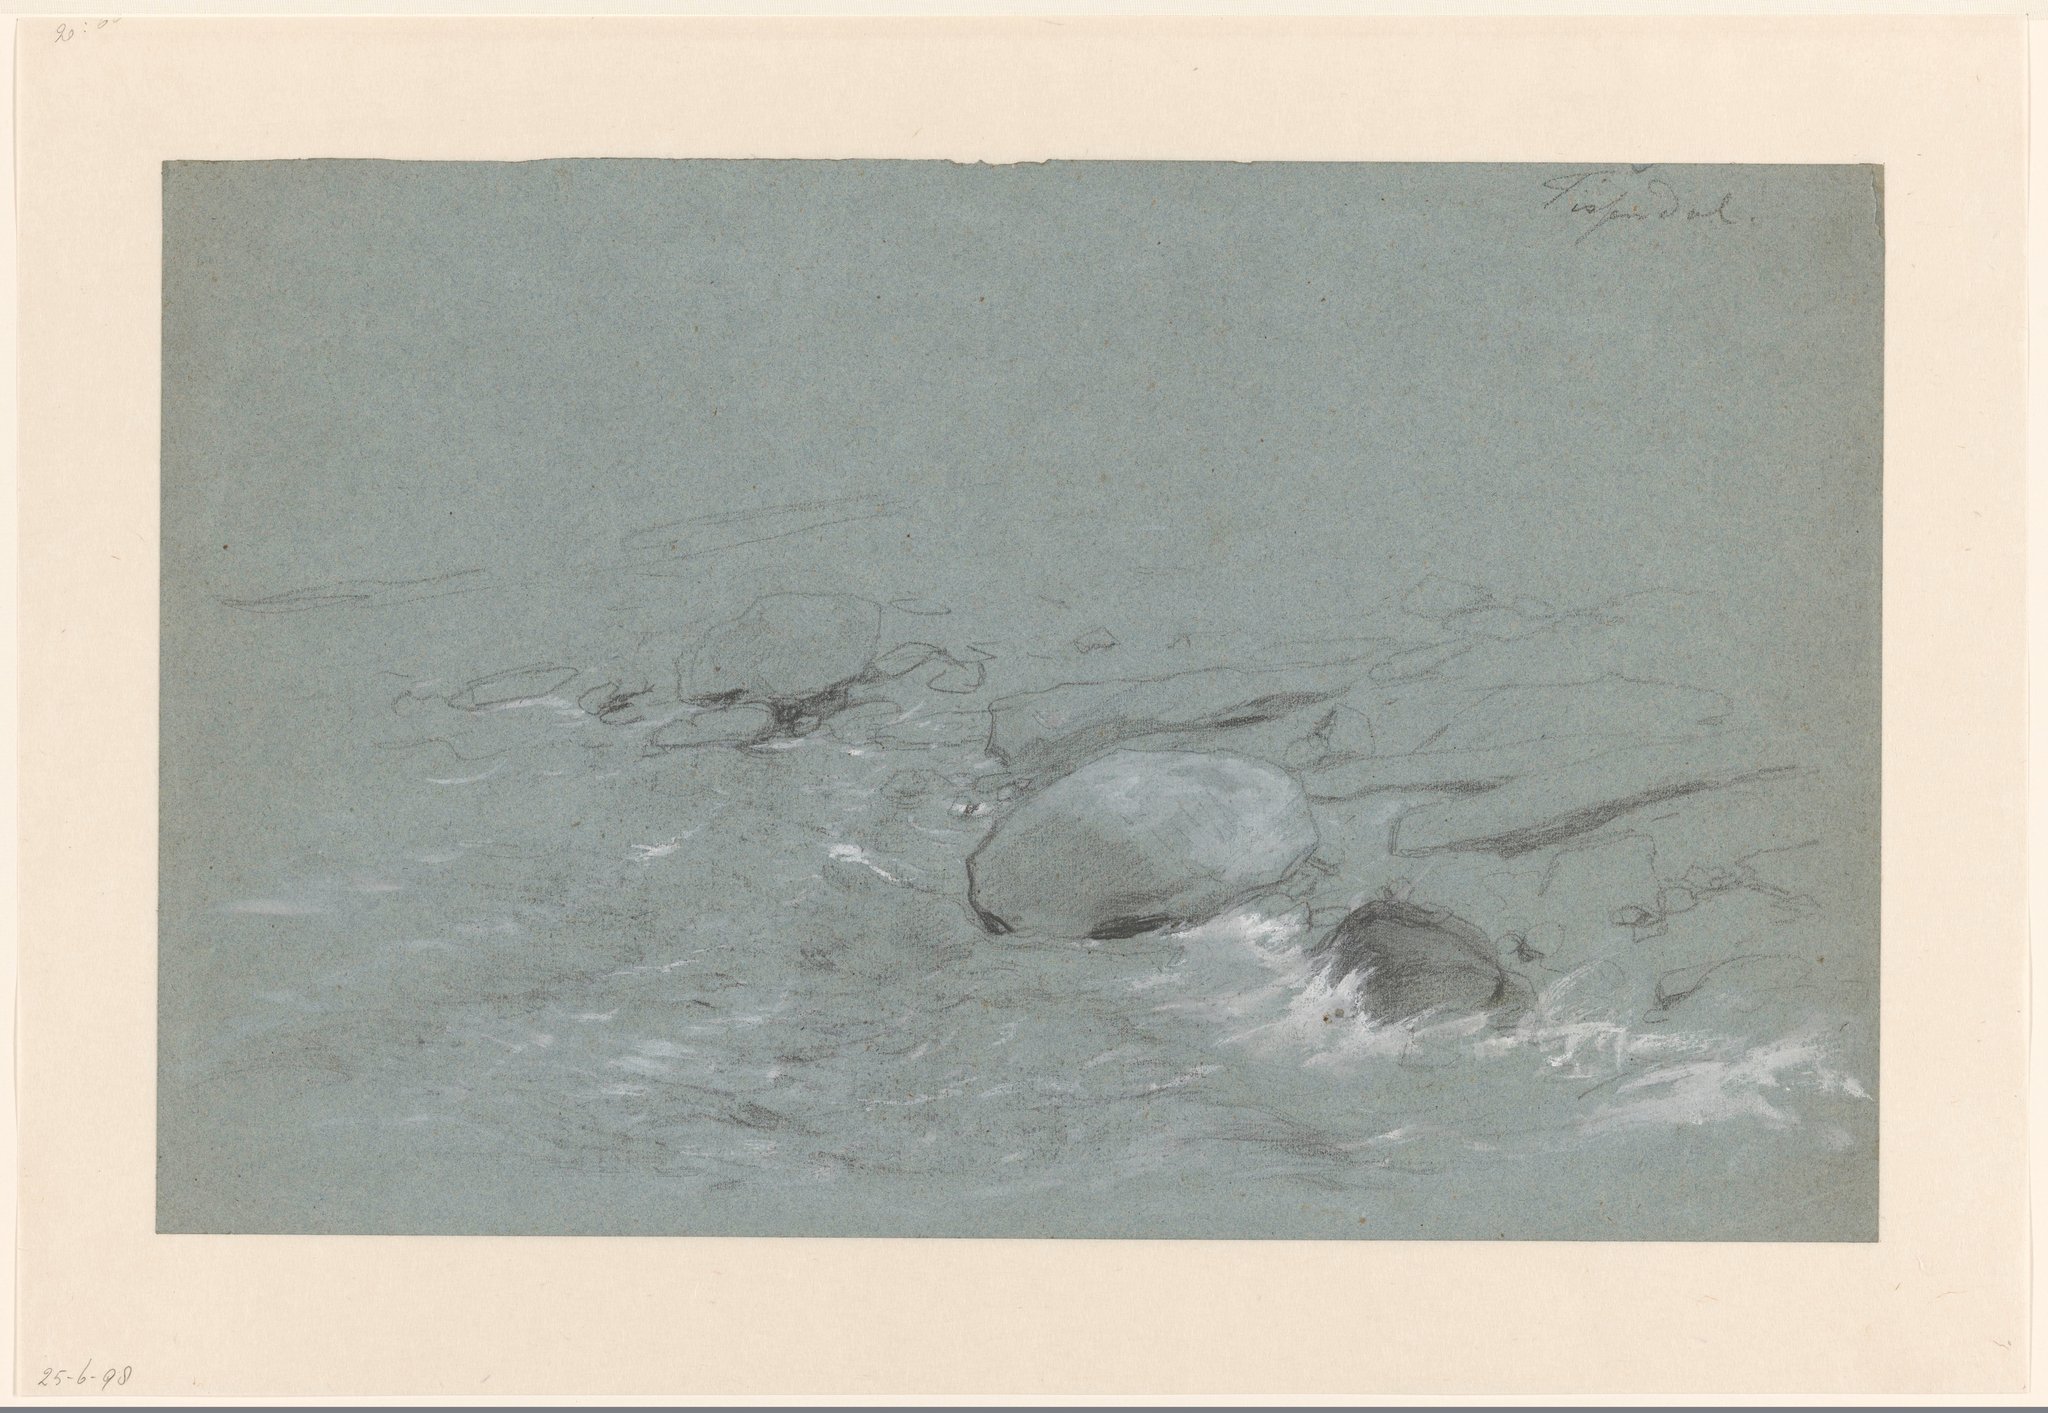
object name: drawing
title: Kustlandschap met keien bij Tyssedal, Noorwegen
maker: willem maris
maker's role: draughtsman, painter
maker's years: 1844-1910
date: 1871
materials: chalk, paper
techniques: brush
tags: coast, rocks, norway